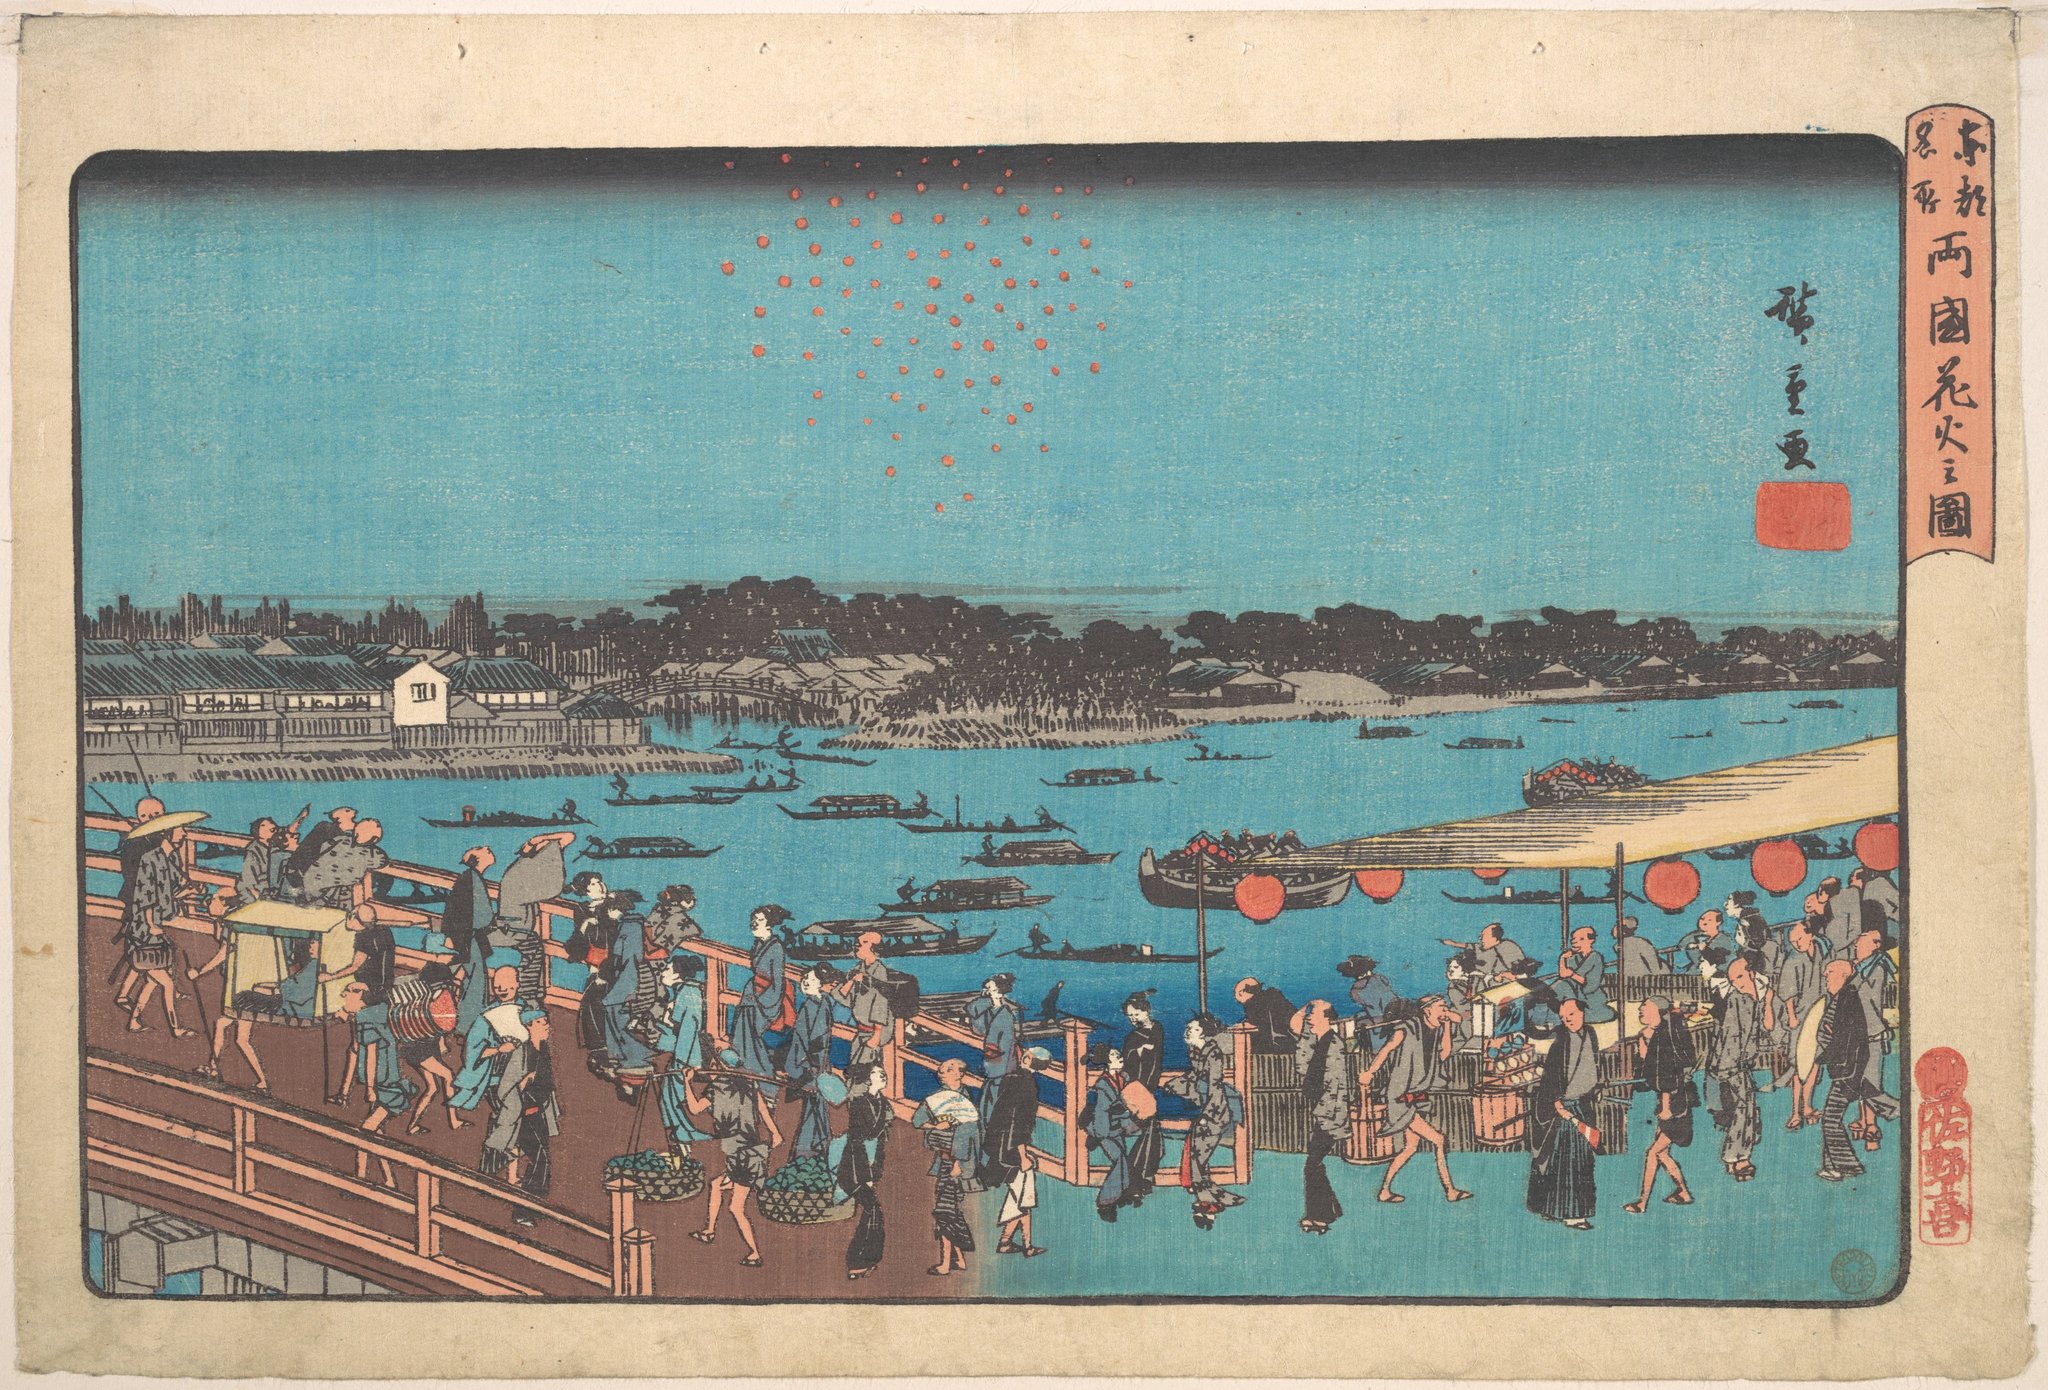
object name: print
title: Ryogoku Hanabi no Zu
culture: japanese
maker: utagawa hiroshige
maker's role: artist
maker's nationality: japanese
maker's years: 1797-1858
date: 1841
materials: ink, paper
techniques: woodblock print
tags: bridges,crowd,boats